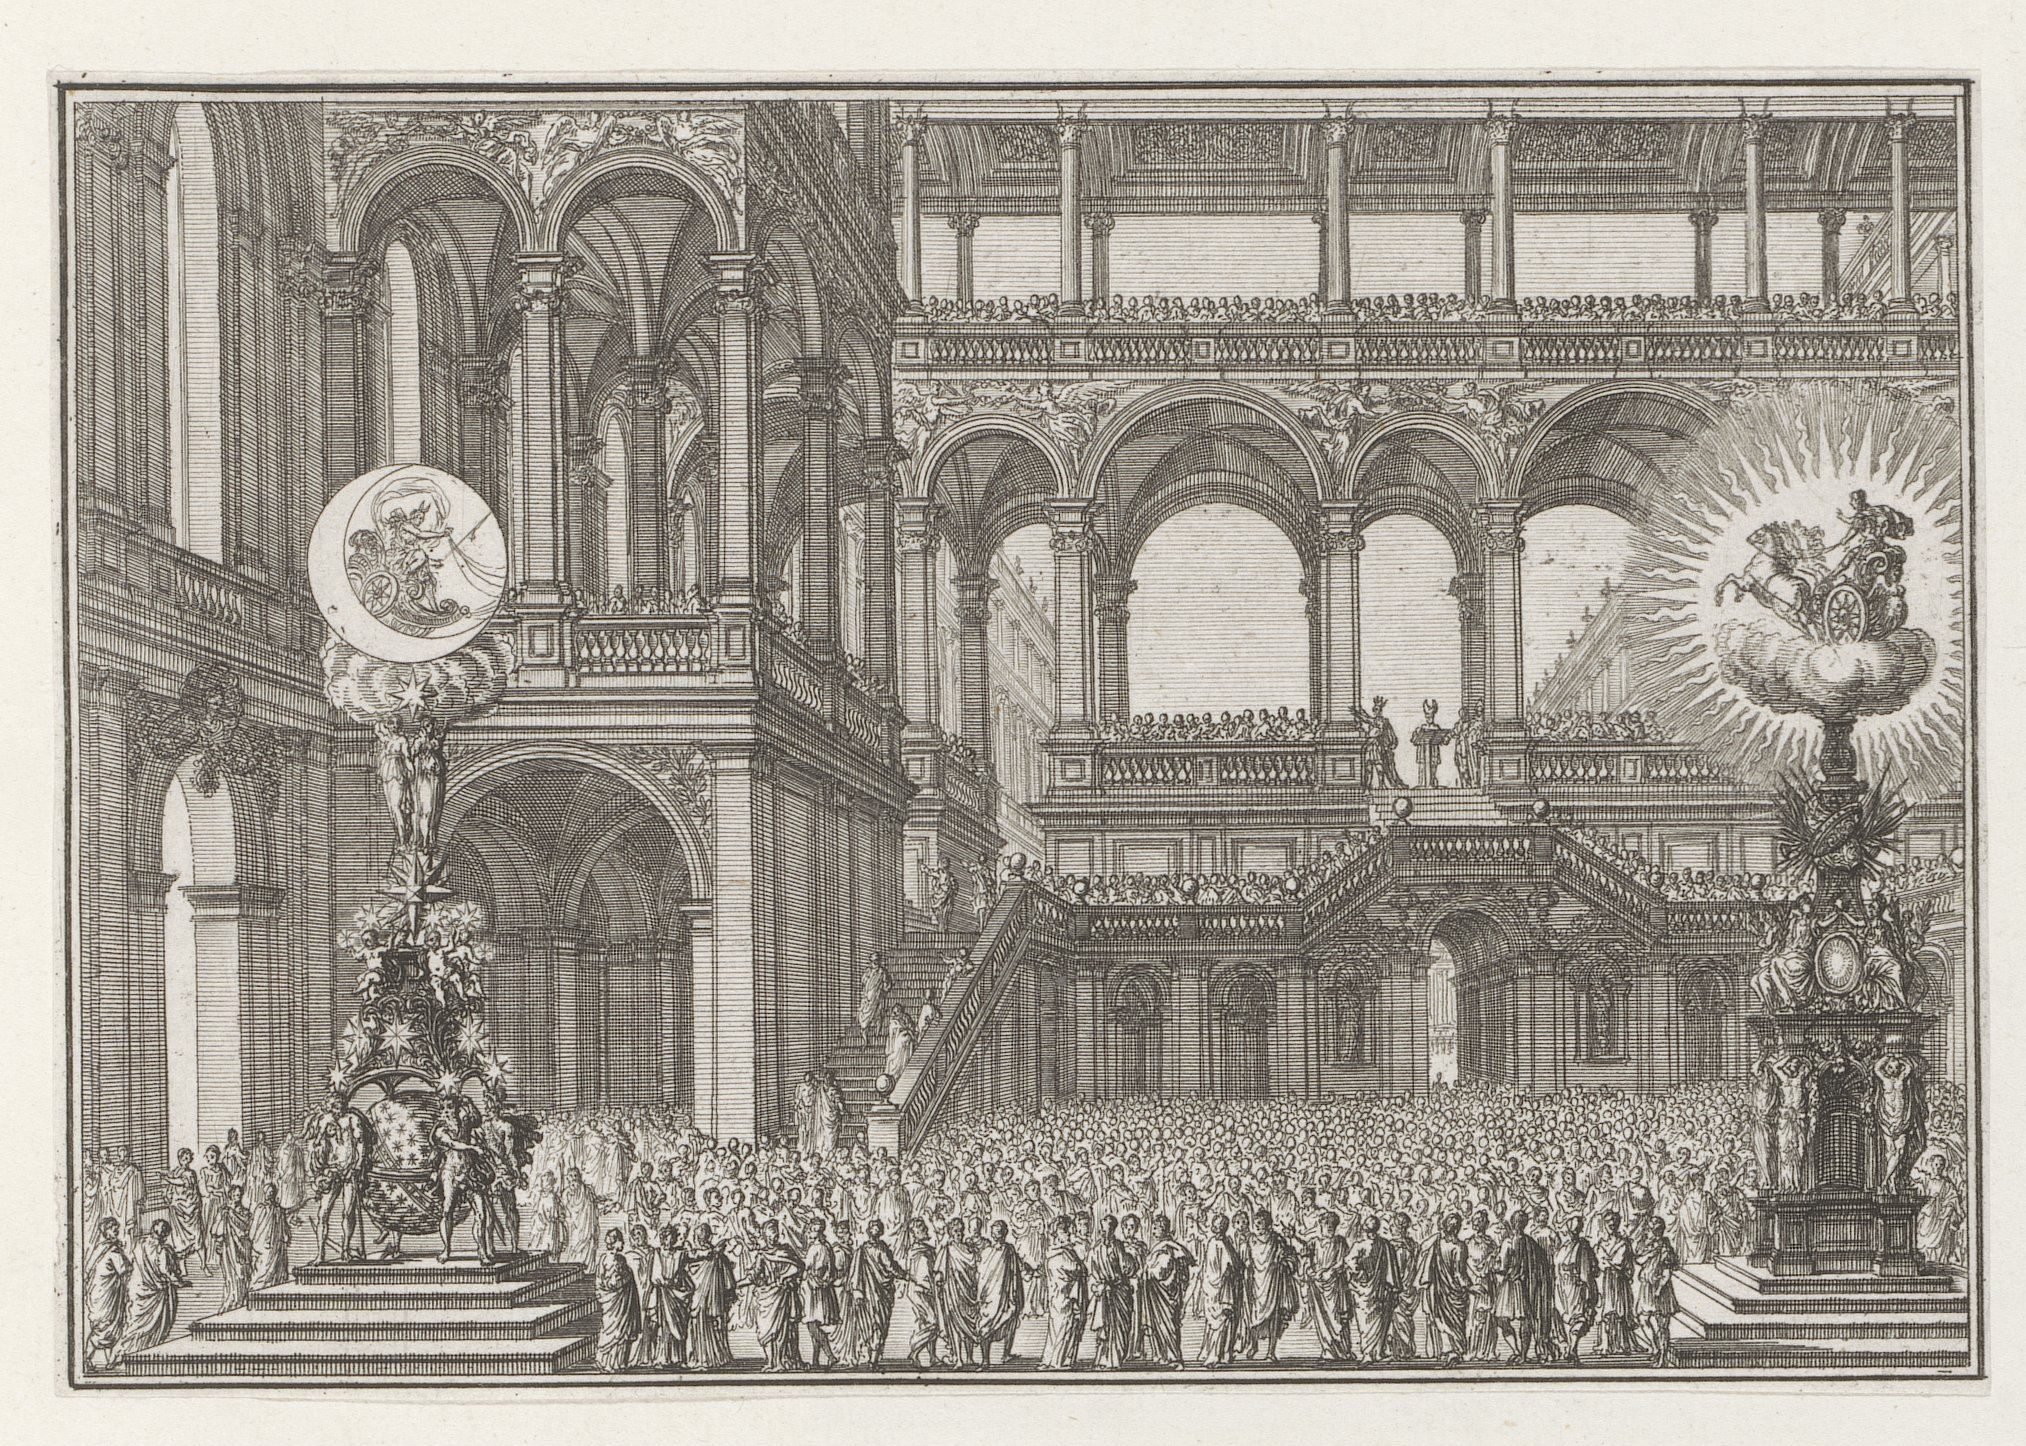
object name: album leaf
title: Magesyn der Italiaense gebouwen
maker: Anonymous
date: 1600-1699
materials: paper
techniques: etching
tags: crowd, mob, piece of sculpture, reproduction of a piece of sculpture, apollo in the chariot of the sun, drawn by four horses, usually preceded by aurora holding a torch; 'carro del sole' (ripa), inner court of palace or 'hôtel'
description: Gezicht op de binnenplaats van een groot paleis. Op de binnenplaats en de balkons rondom staat een menigte mensen. Op de voorgrond rechts een ornamentele baldakijn met bovenop Apollo in zijn zonnewagen. De prent maakt deel uit van een album.